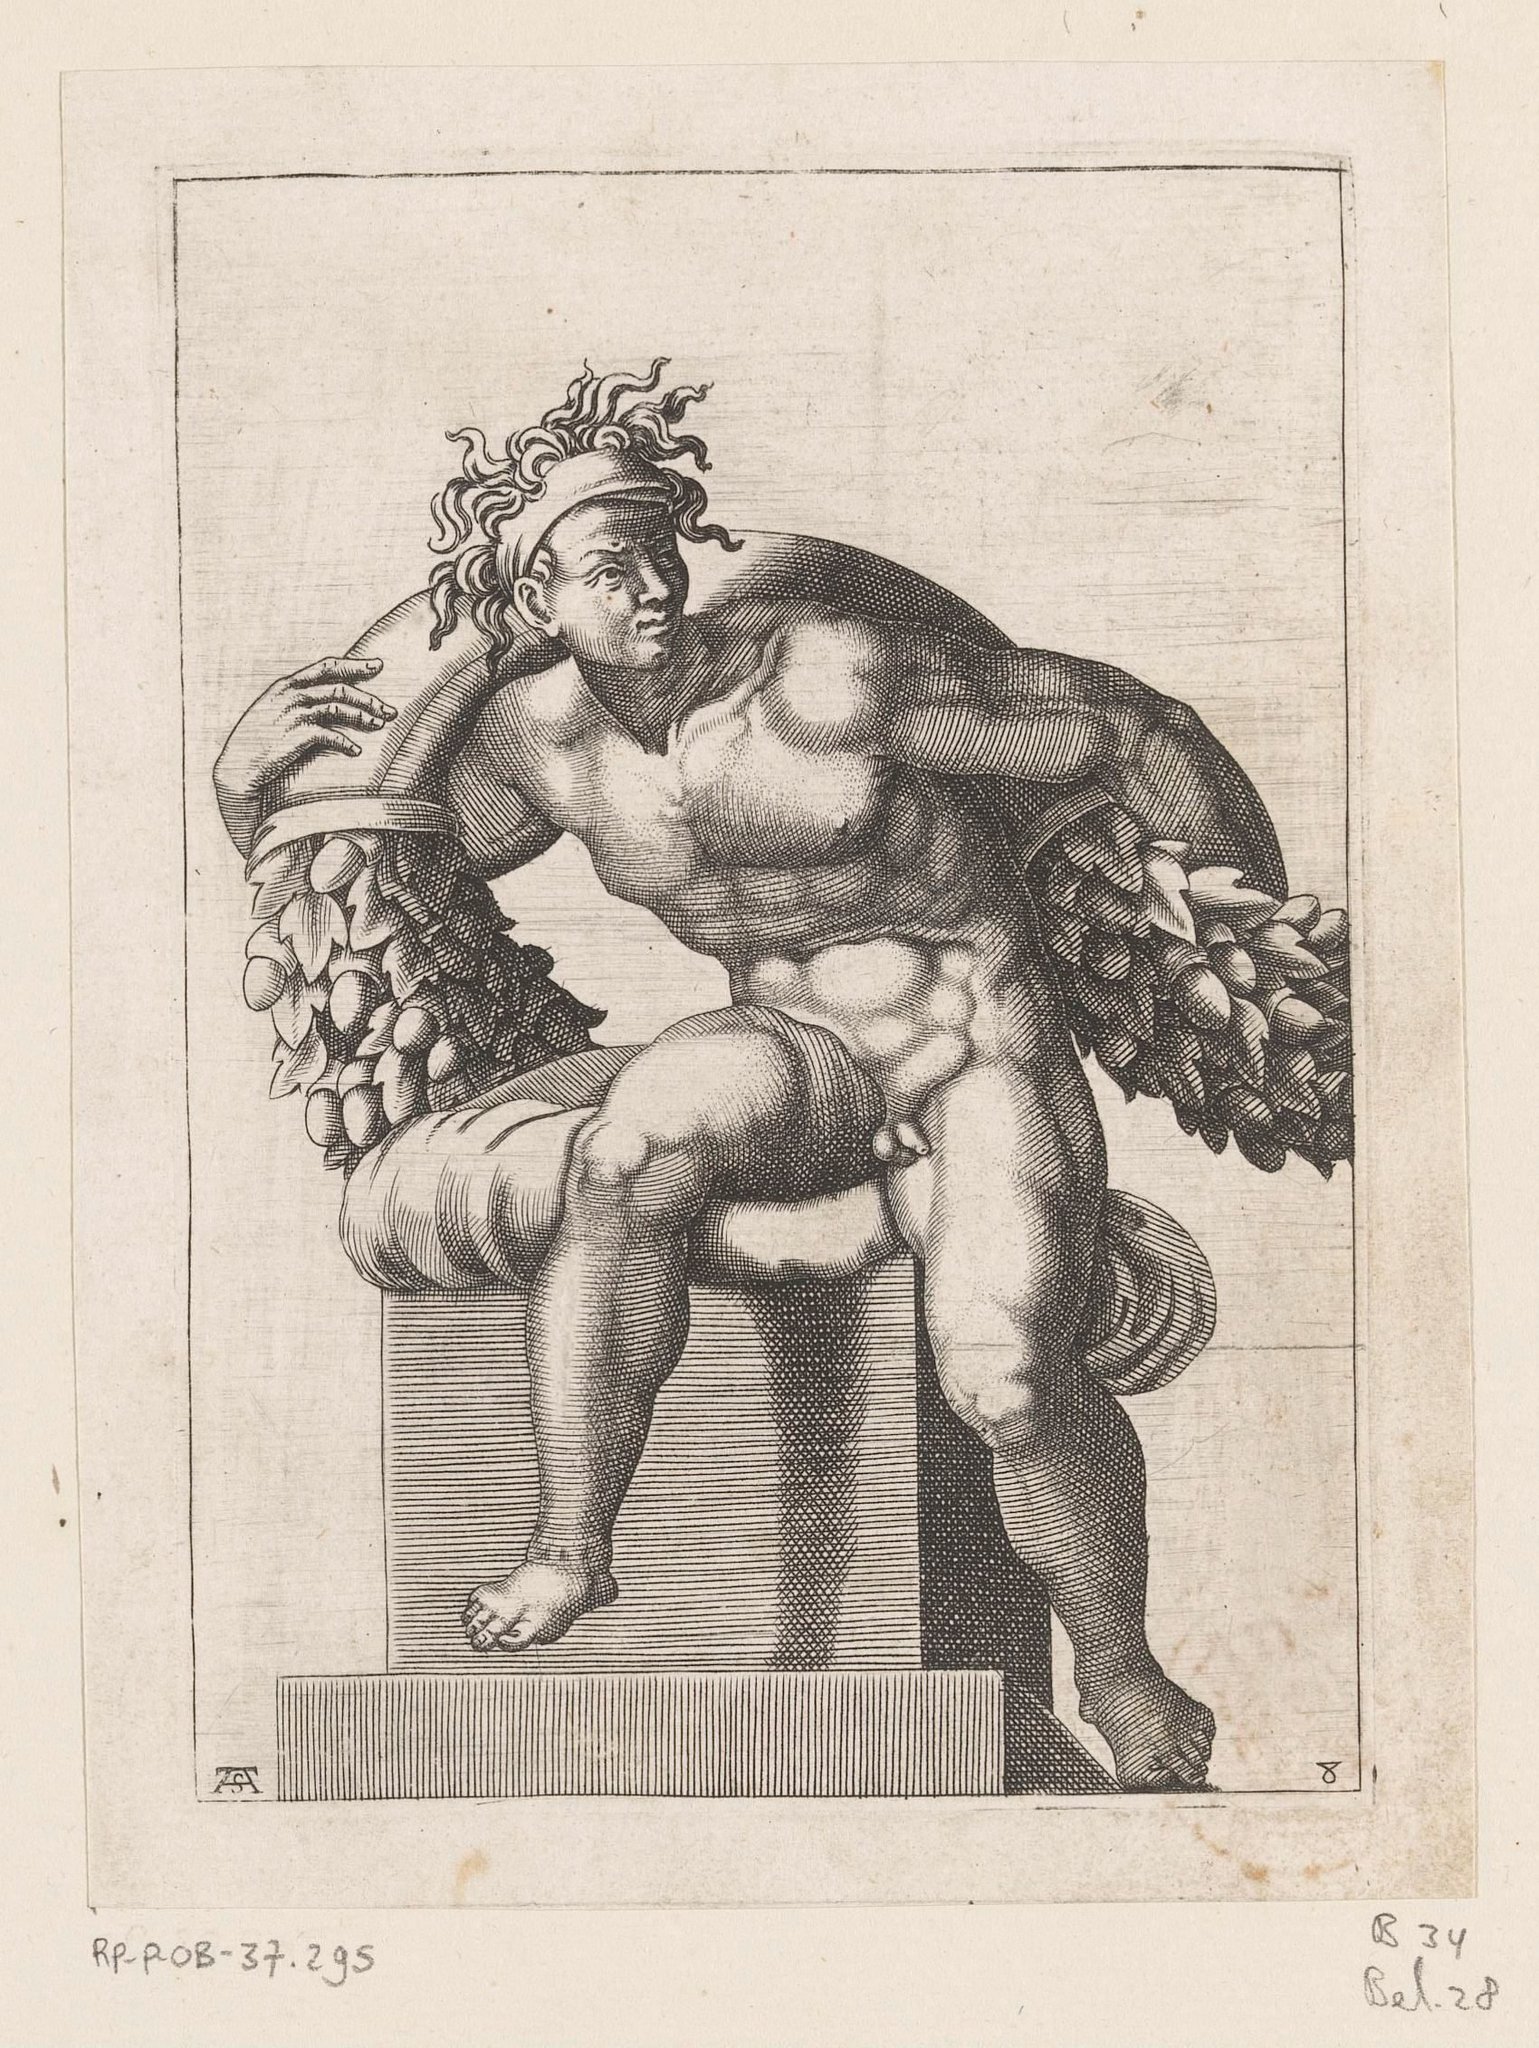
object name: print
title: Zittend naakt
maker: adamo scultori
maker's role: painter, print maker, sculptor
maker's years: 1530-1585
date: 1585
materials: paper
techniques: engraving, intaglio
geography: vatican city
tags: the (nude) human figure; 'corpo humano' (ripa), fruits: acorn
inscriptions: collector's mark: Lugt 240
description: Naakte man zittend op een kussen, gedeeltelijk naar rechts gedraaid, met een guirlande van eikels. Eén van de 'ignudi' (naakte mannen) van Michelangelo's plafondschildering. Genummerd rechtsonder: 8.